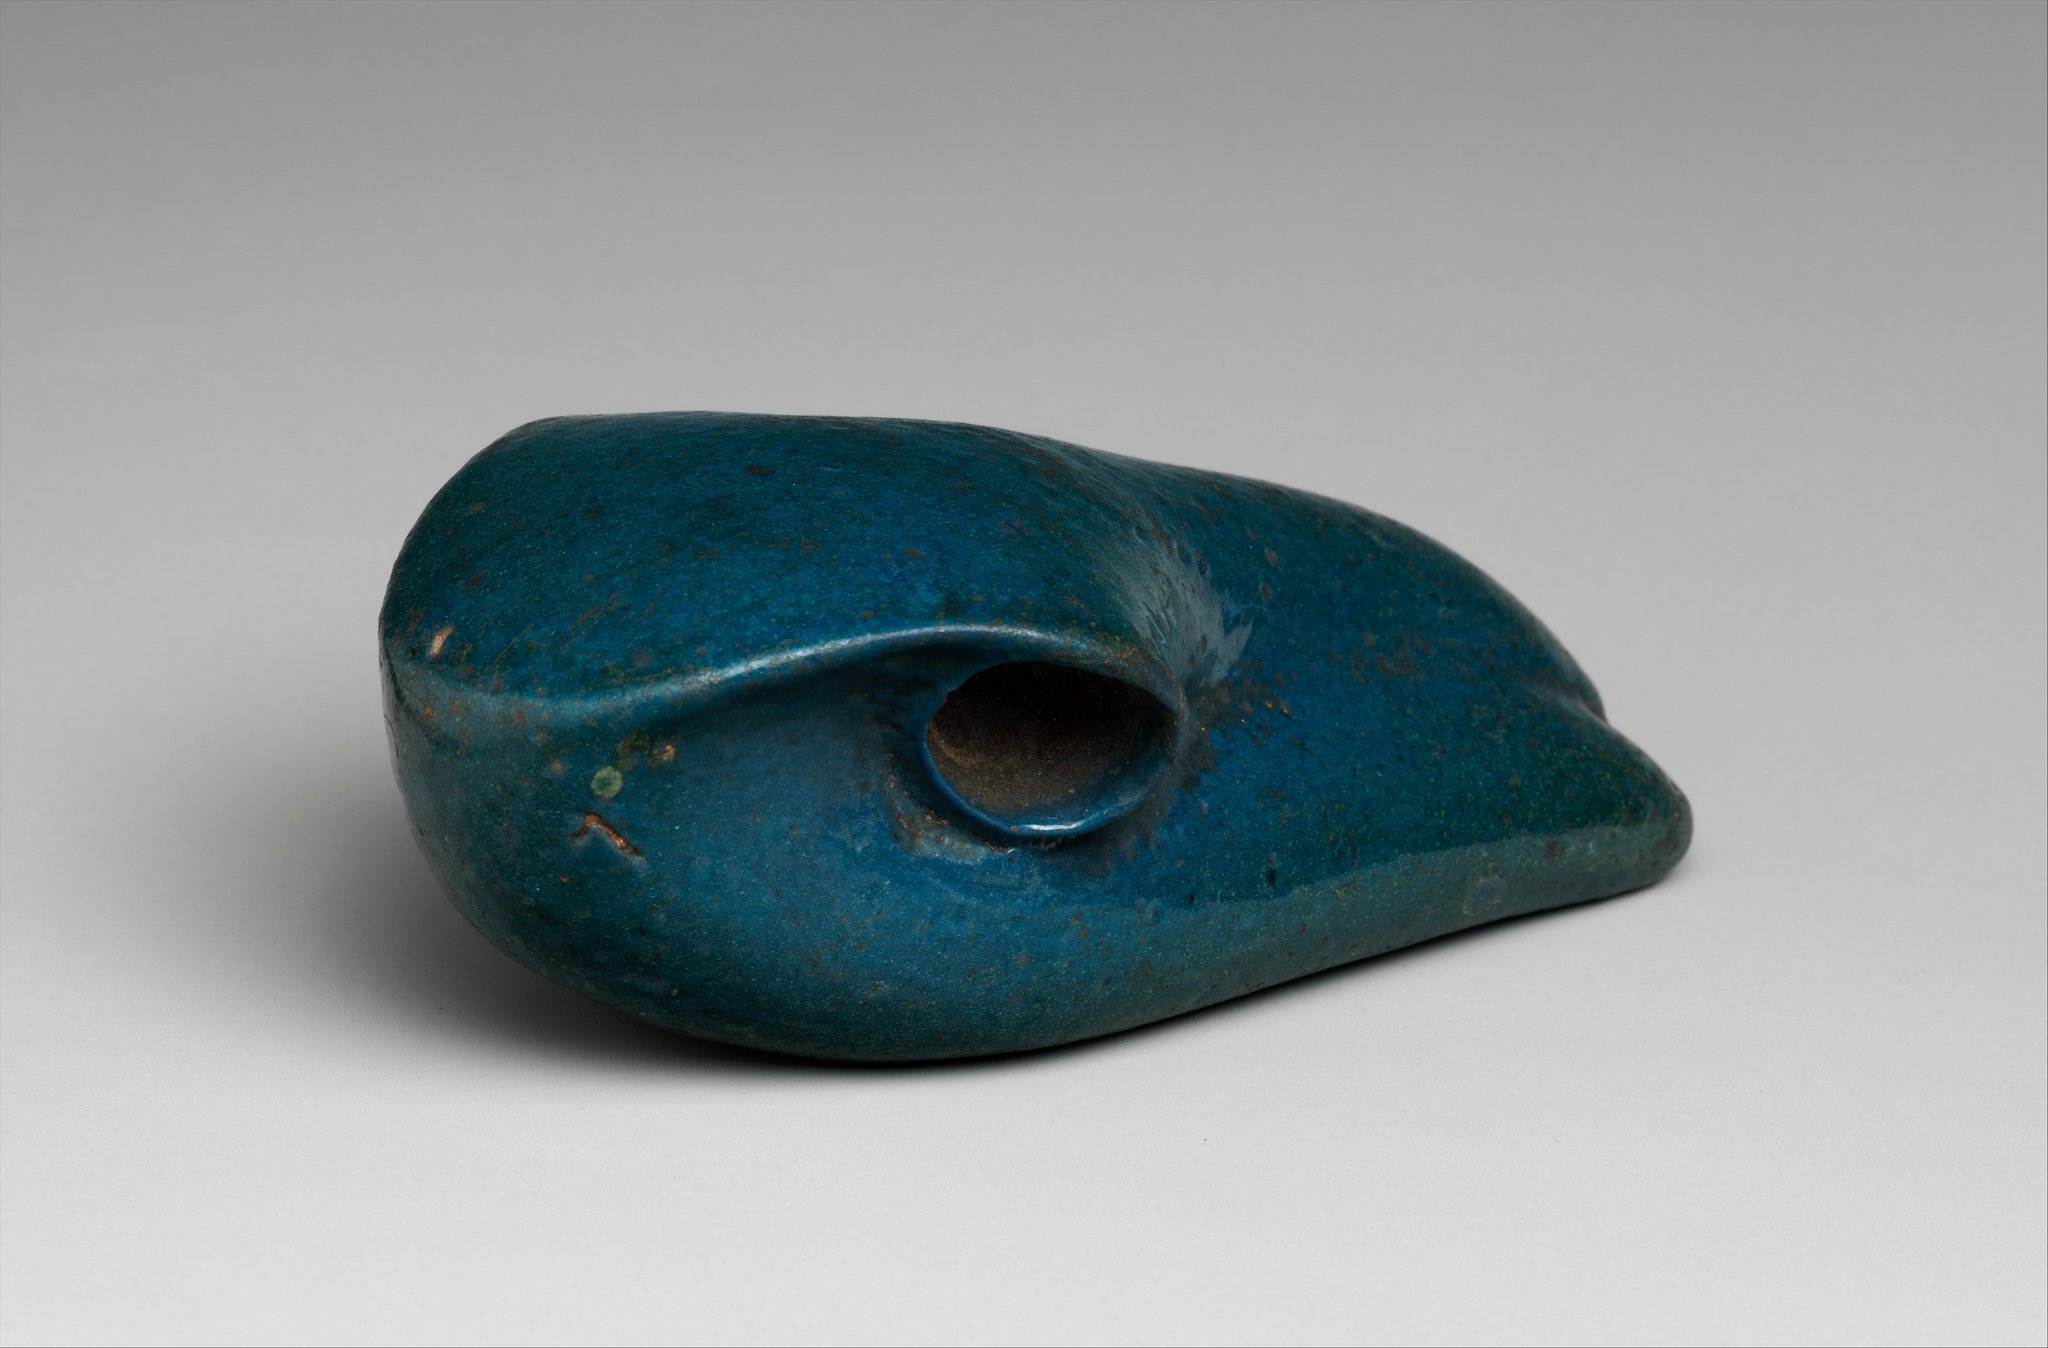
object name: architectural ornament, cobra head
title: Cobra Head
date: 1400-1300 BCE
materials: faience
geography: egypt